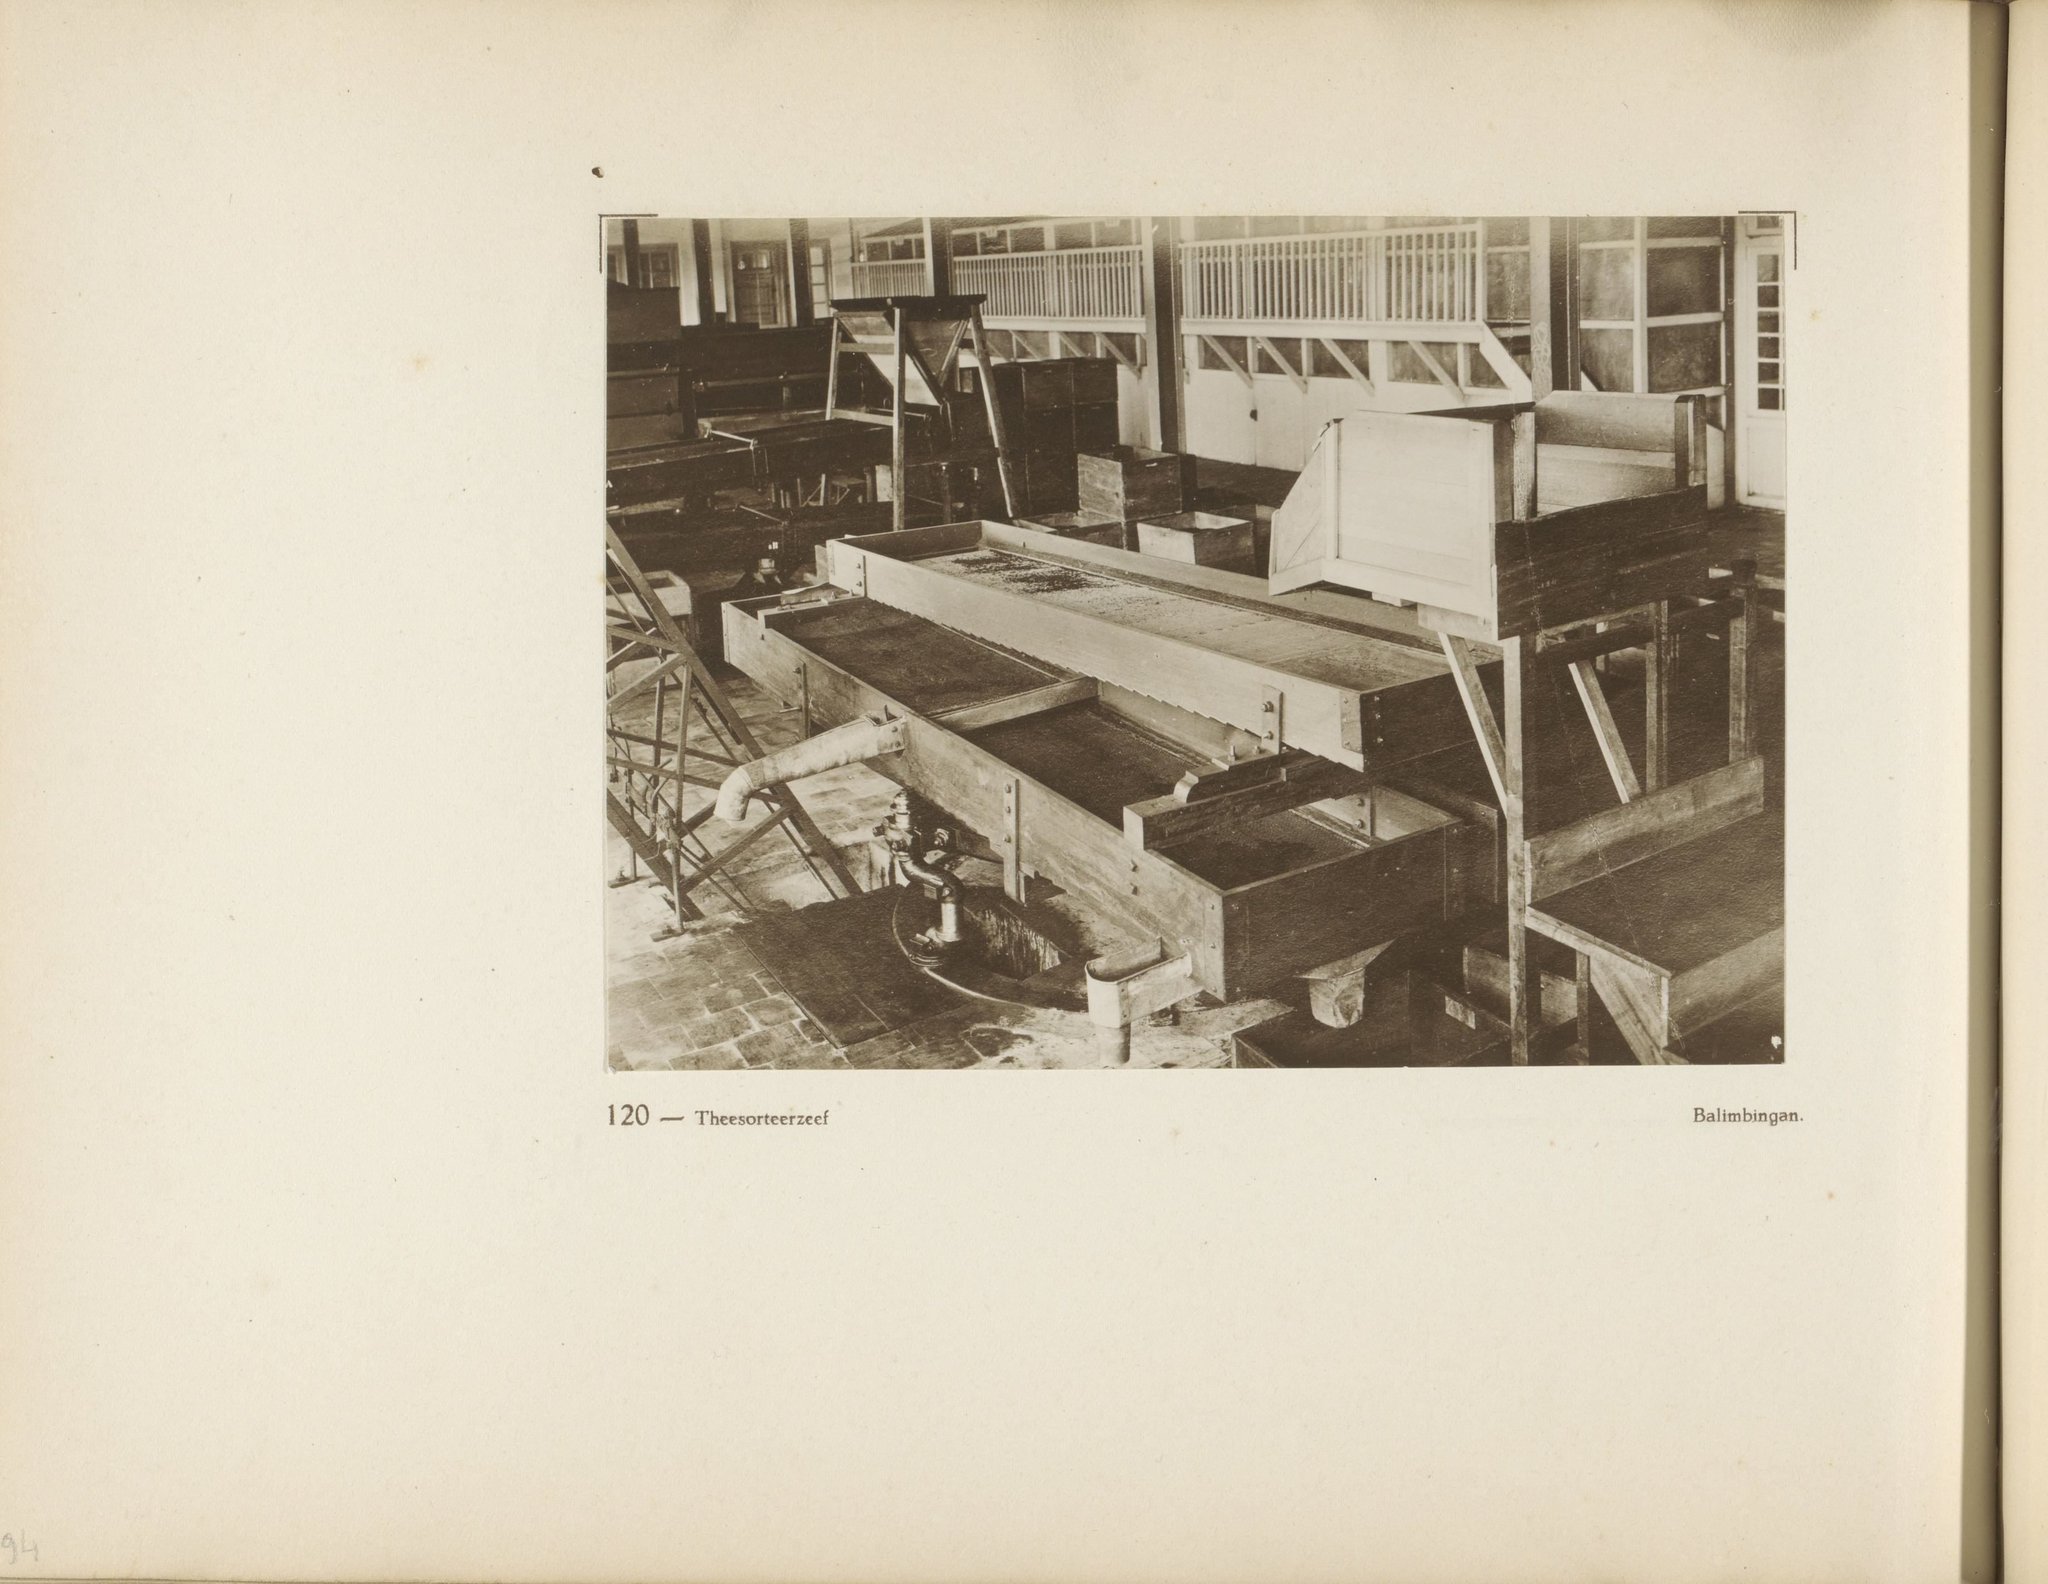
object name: album leaf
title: Pagina 120 van fotoboek van de Algemeene Vereeniging van Rubberplanters ter Oostkust van Sumatra (A.V.R.O.S.)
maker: j.w. meyster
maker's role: fotograaf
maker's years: 1887-1945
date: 1924-1925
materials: paper, photographic support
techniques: printing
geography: dutch east indies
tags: factory-interior, machine shop, (non-fruit) products of plants or trees: rubber, machines, engines ~ crafts and industries (+ agricultural processes), tea (leaves), sumatra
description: Boekpagina met een foto van een theesorteerzeef in een theefabriek te Balimbingan. Onderdeel van een fotoboek van de Algemeene Vereeniging van Rubberplanters ter Oostkust van Sumatra (A.V.R.O.S.).